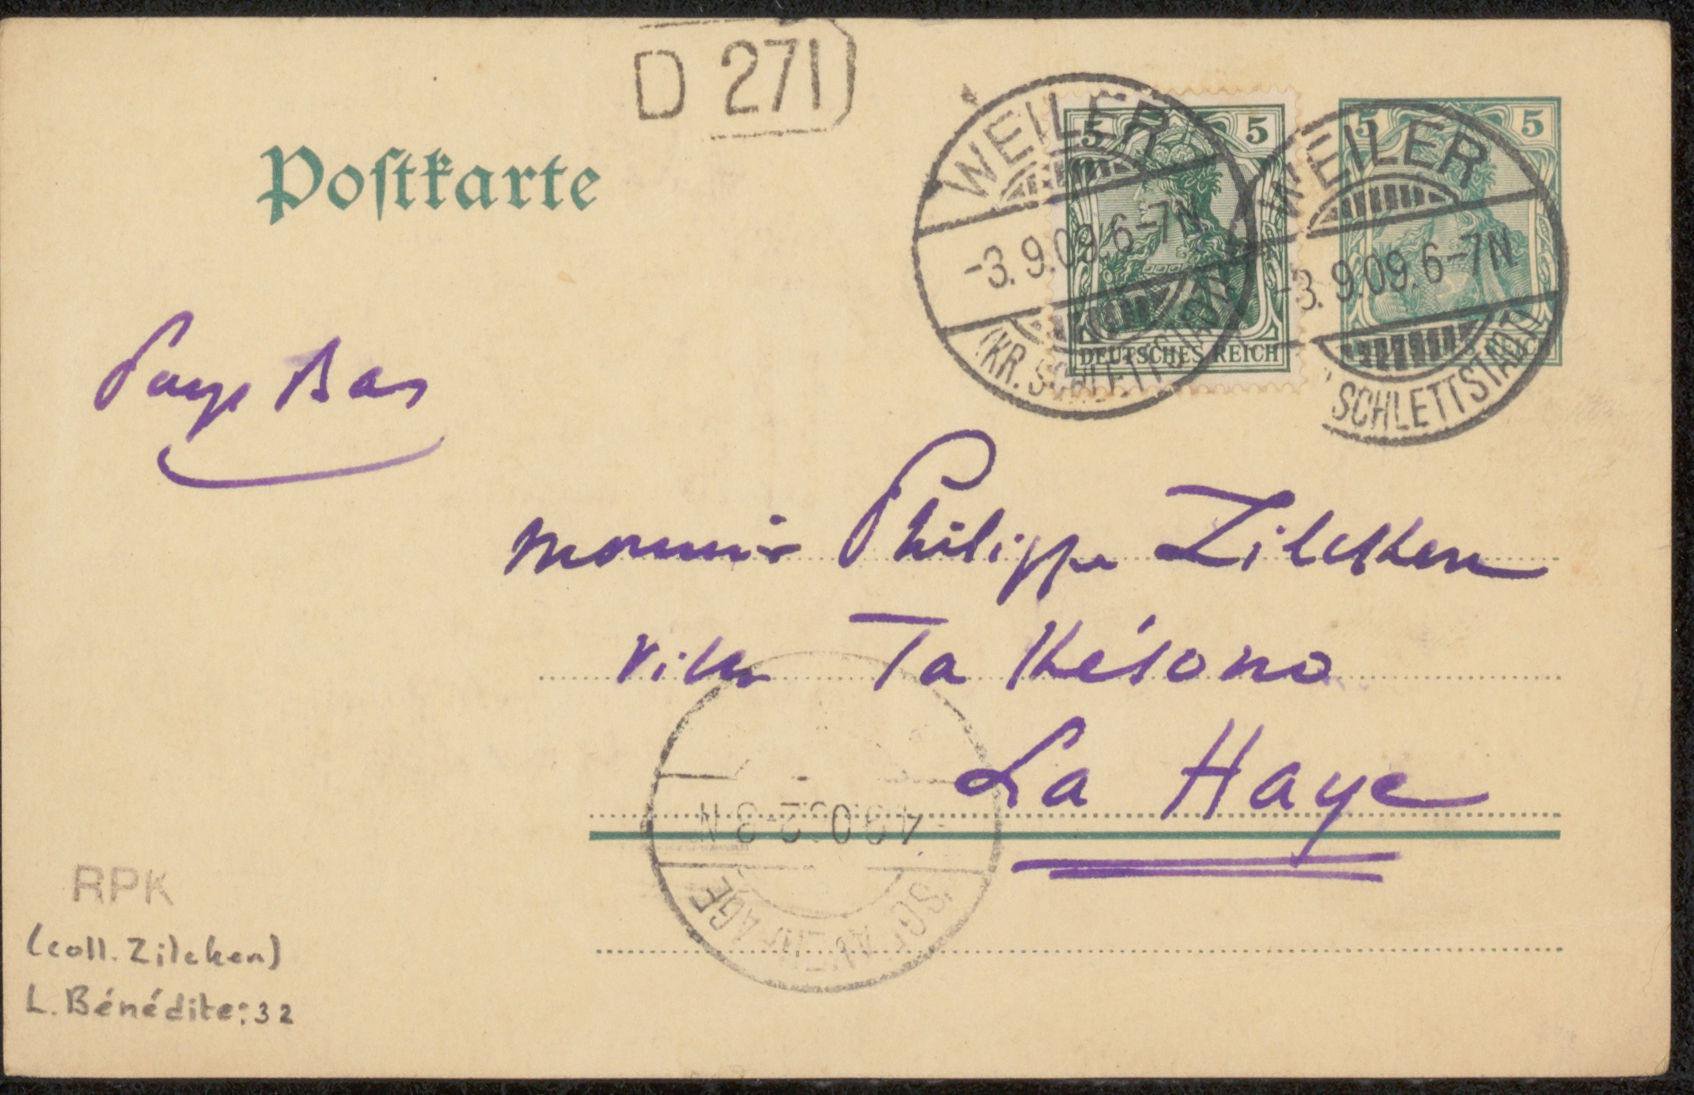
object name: postcard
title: Briefkaart aan Philip Zilcken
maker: léonce bénédite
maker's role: conservator, museumdirecteur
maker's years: 1856-1925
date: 1909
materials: cardboard, ink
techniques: pen, writing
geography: weiler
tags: the hague, painter, draughtsman, philip zilcken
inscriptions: collector's mark: ‘RPK’